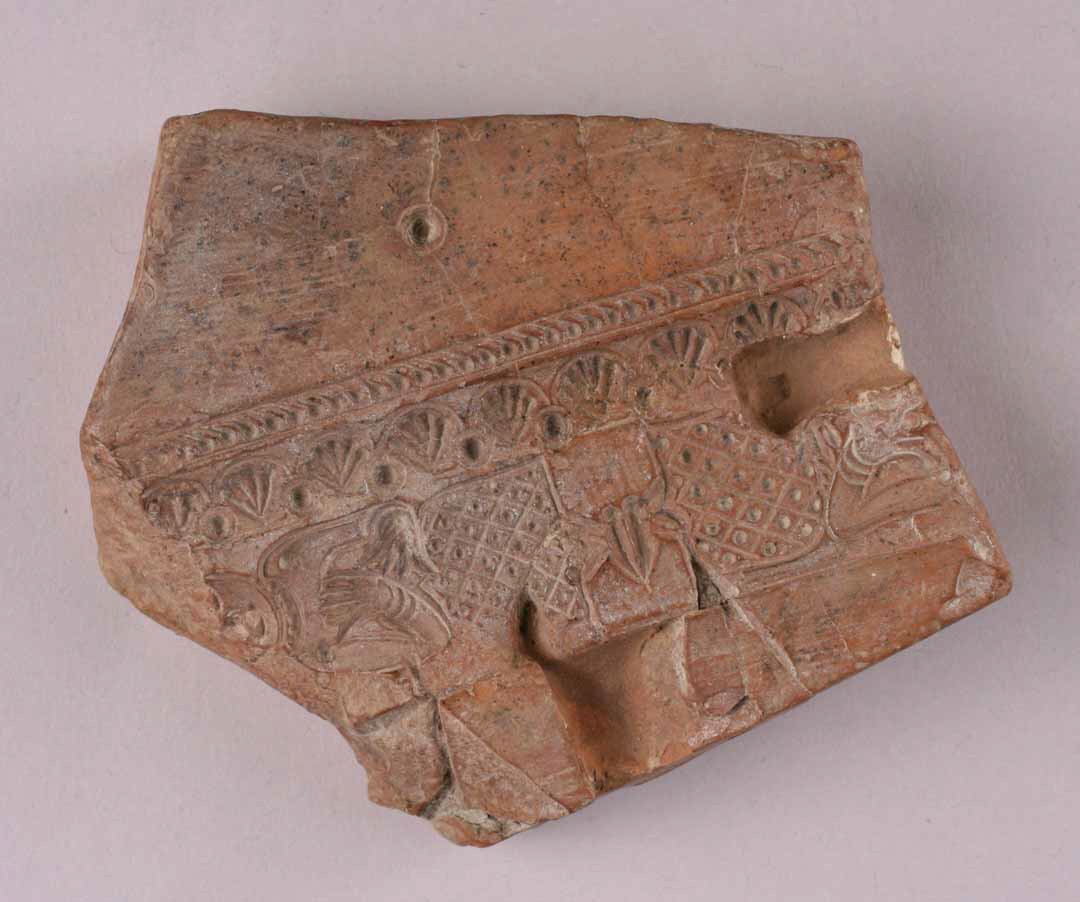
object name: mold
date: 867-933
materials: clay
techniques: molding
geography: iran